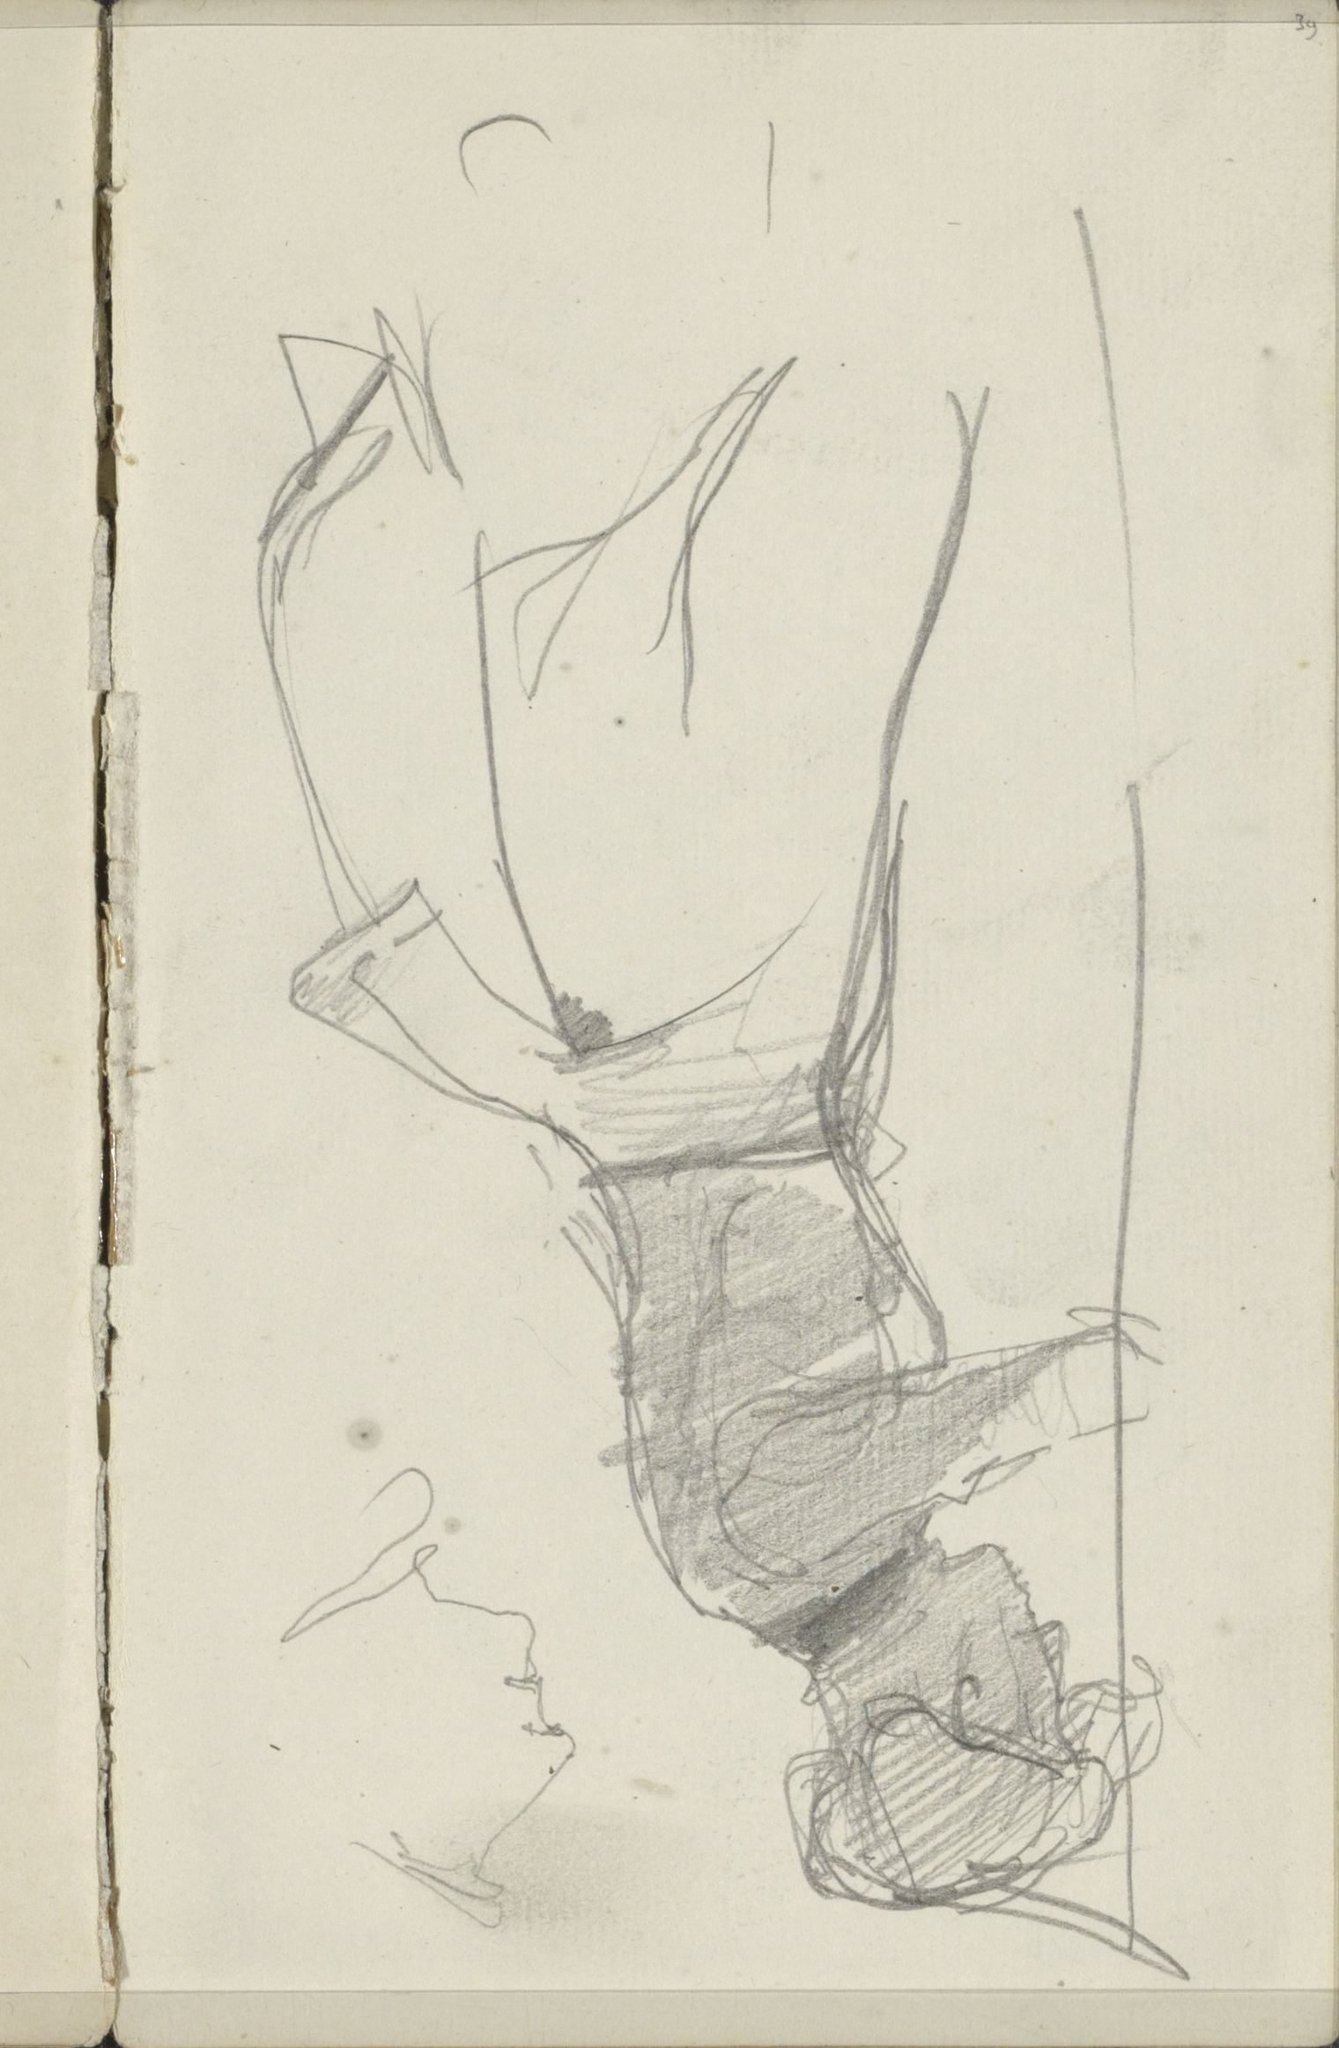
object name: sketchbook leaf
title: Staande vrouw, in profiel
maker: george hendrik breitner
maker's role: draughtsman, painter, print maker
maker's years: 1857-1923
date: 1880-1882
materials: paper, pencil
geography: the hague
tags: head (human), adult woman, standing figure - aa - female human figure (+ sideview, profile)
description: Ernaast een hoofd. Pagina 39 uit een schetsboek met 25 bladen.